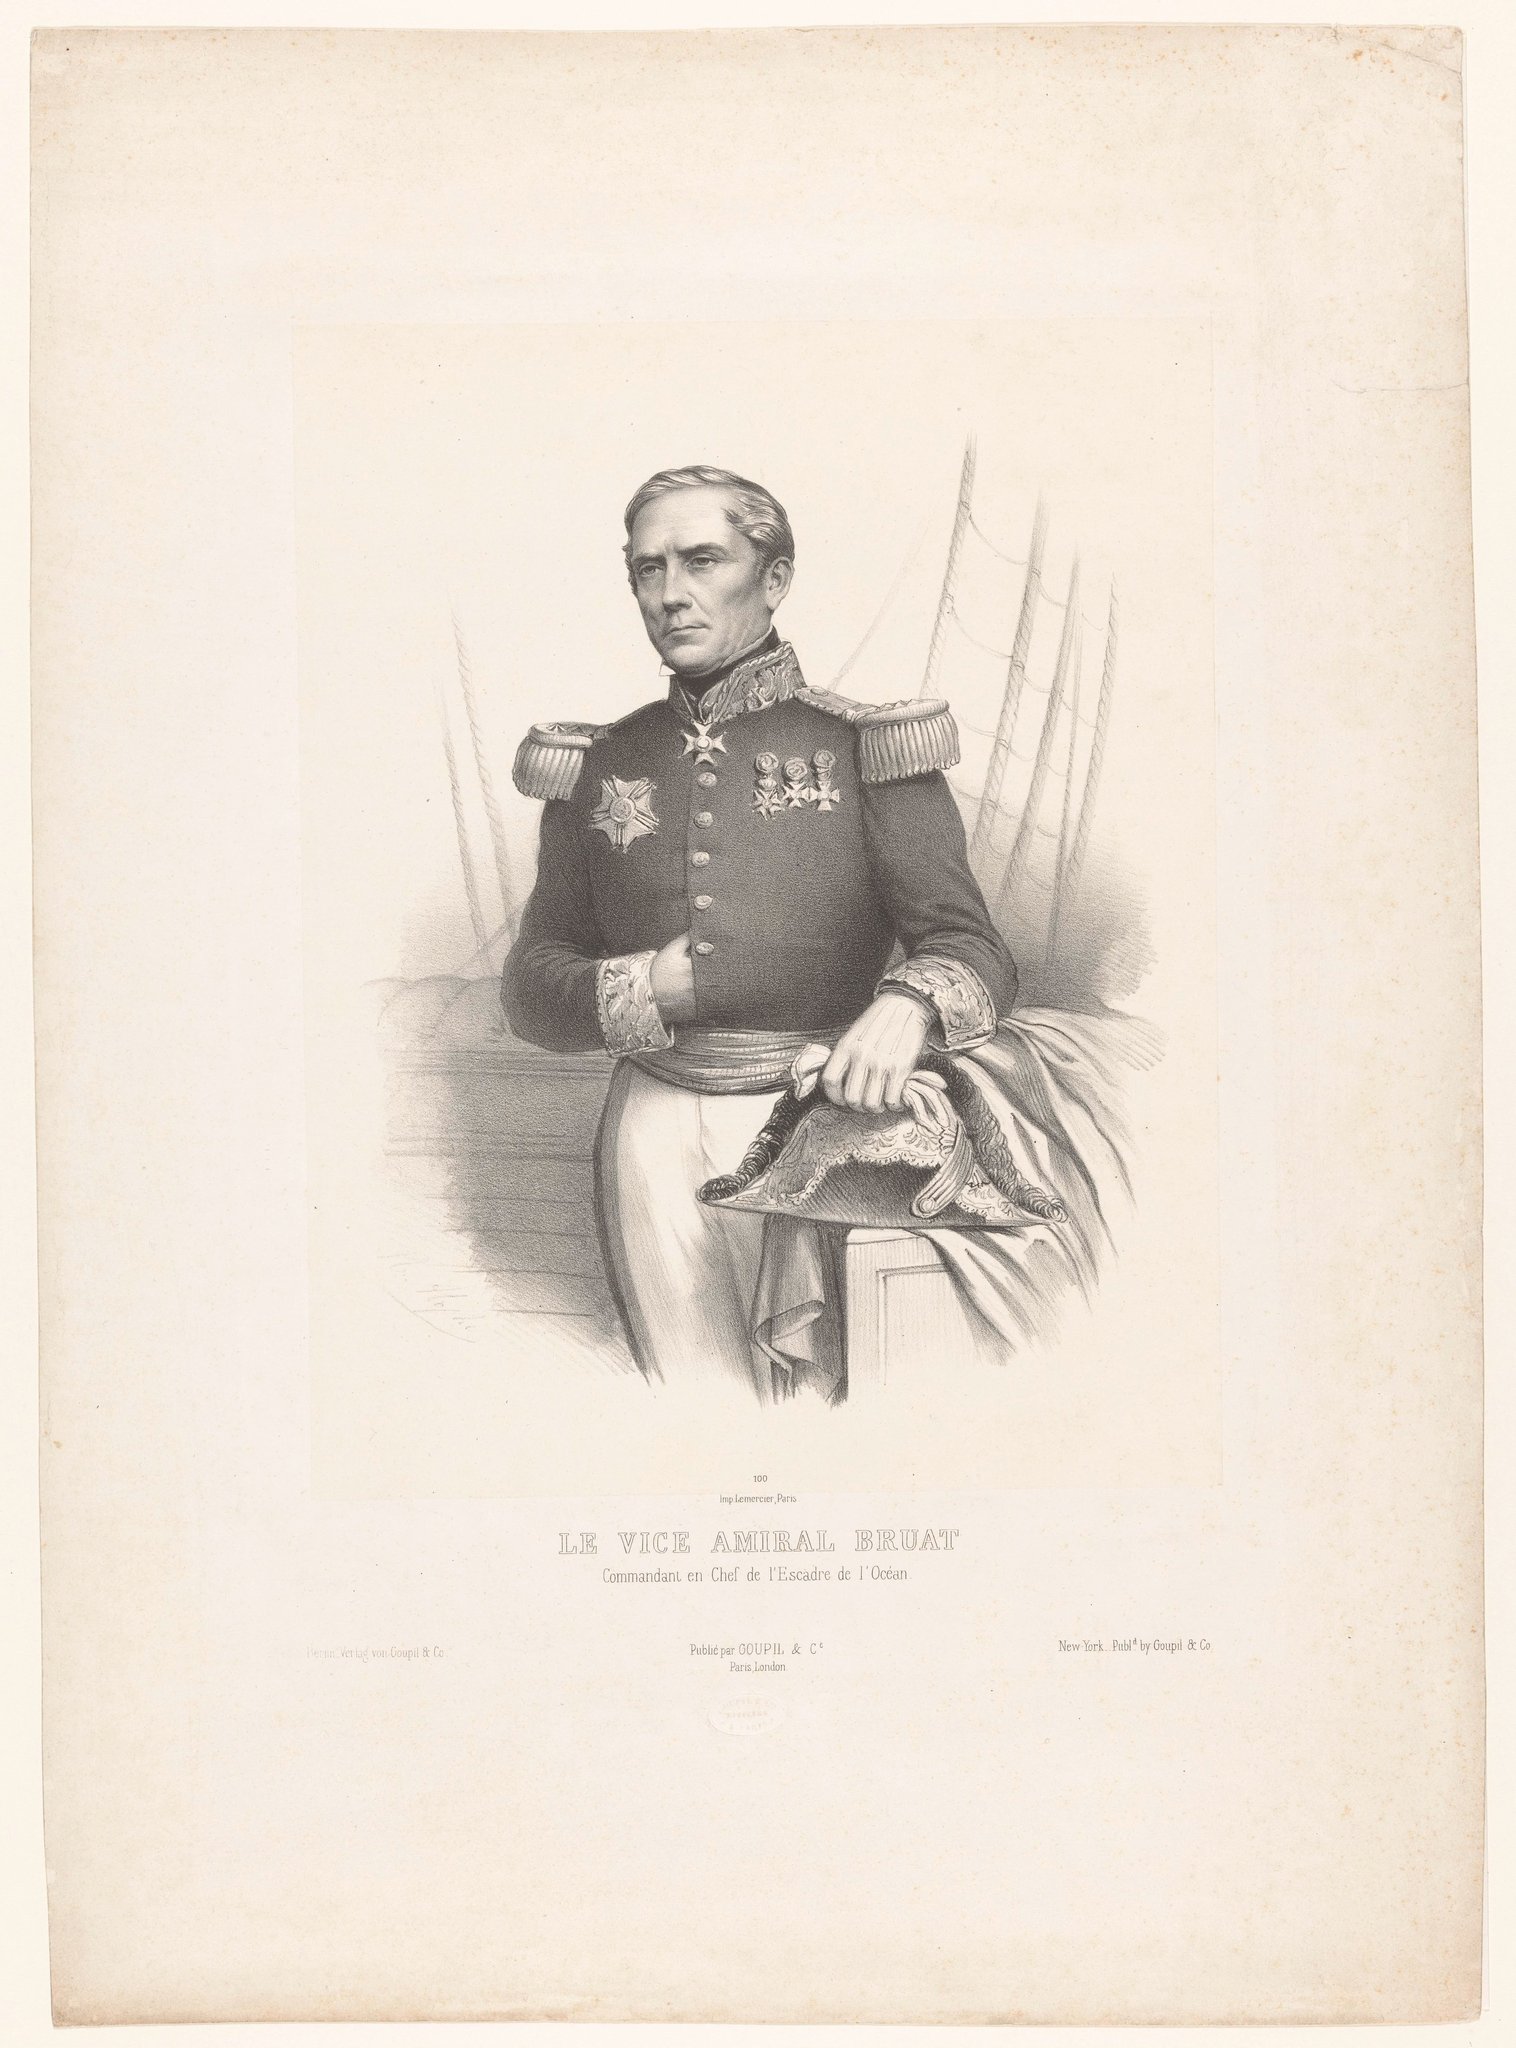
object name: print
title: Portret van admiraal Armand Joseph Bruat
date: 1854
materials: paper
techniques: lithography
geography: new york city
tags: naval officer, historical persons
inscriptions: collector's mark: Lugt 2228, check stamp: Lugt 1090